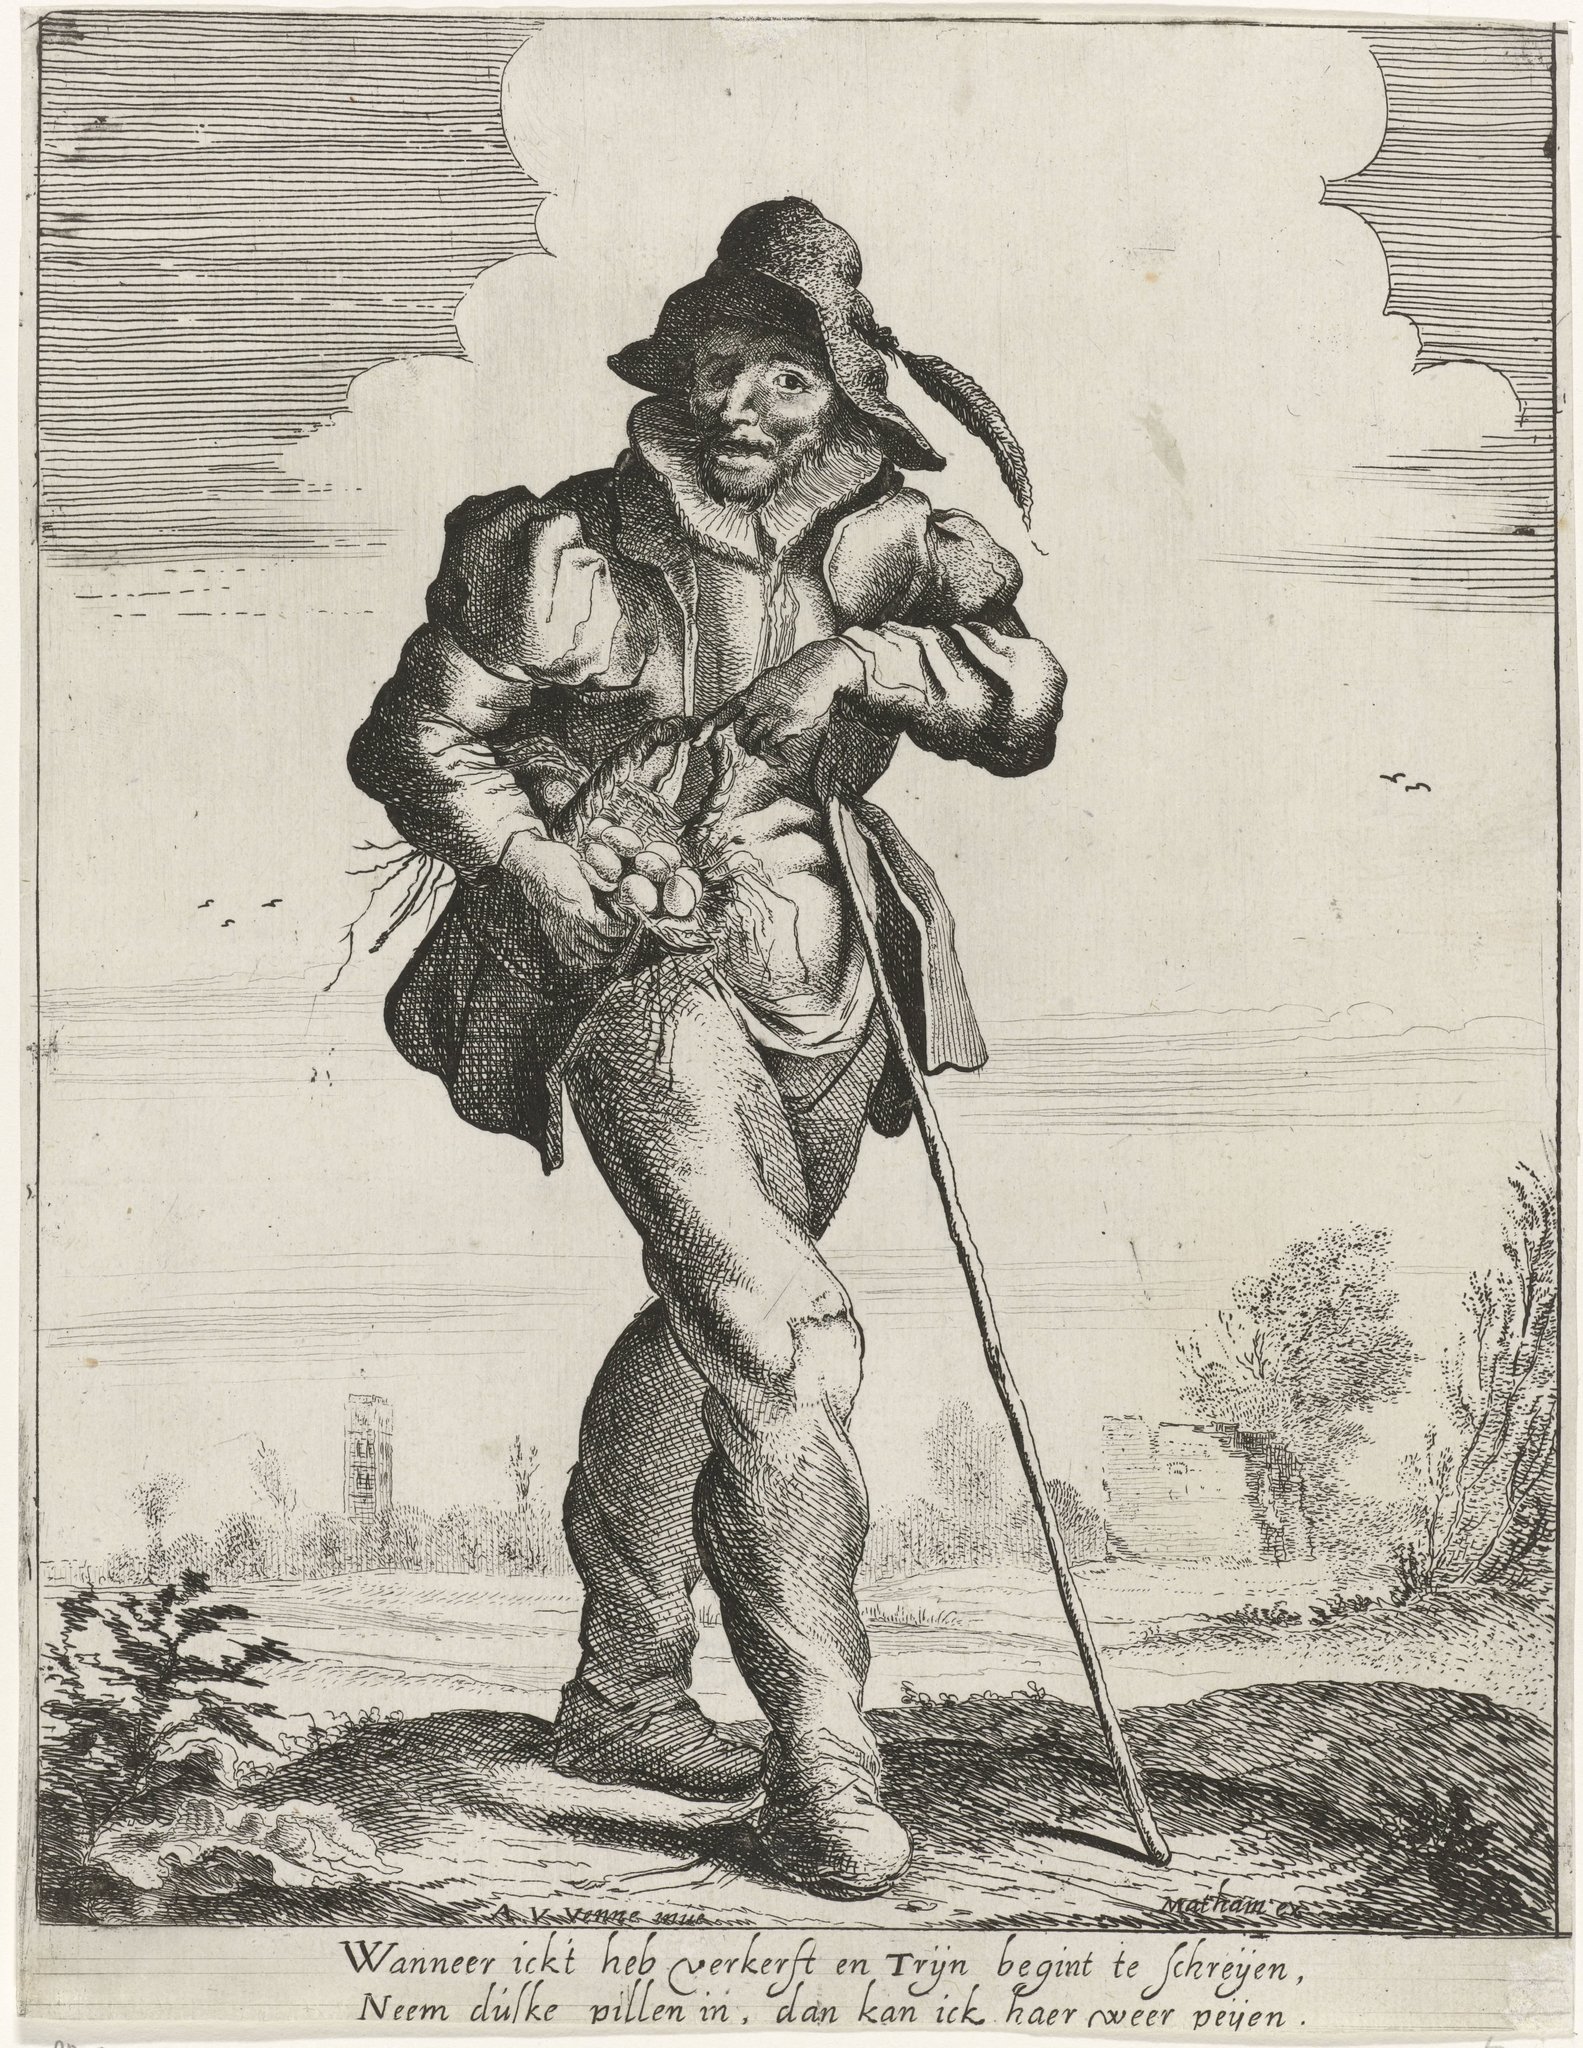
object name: print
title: Boer met eieren in een mand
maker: jan matham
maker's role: print maker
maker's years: 1600-1648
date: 1628-1648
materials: paper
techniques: engraving, etching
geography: haarlem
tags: farmers, carrying something in basket, bag, rucksack, etc., eggs, egg-dishes, index finger forwards, pointing, indicating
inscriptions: collector's mark: Lugt 2228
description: Een staande boer in een landschap wijst op een mand met eieren die hij onder zijn arm heeft.